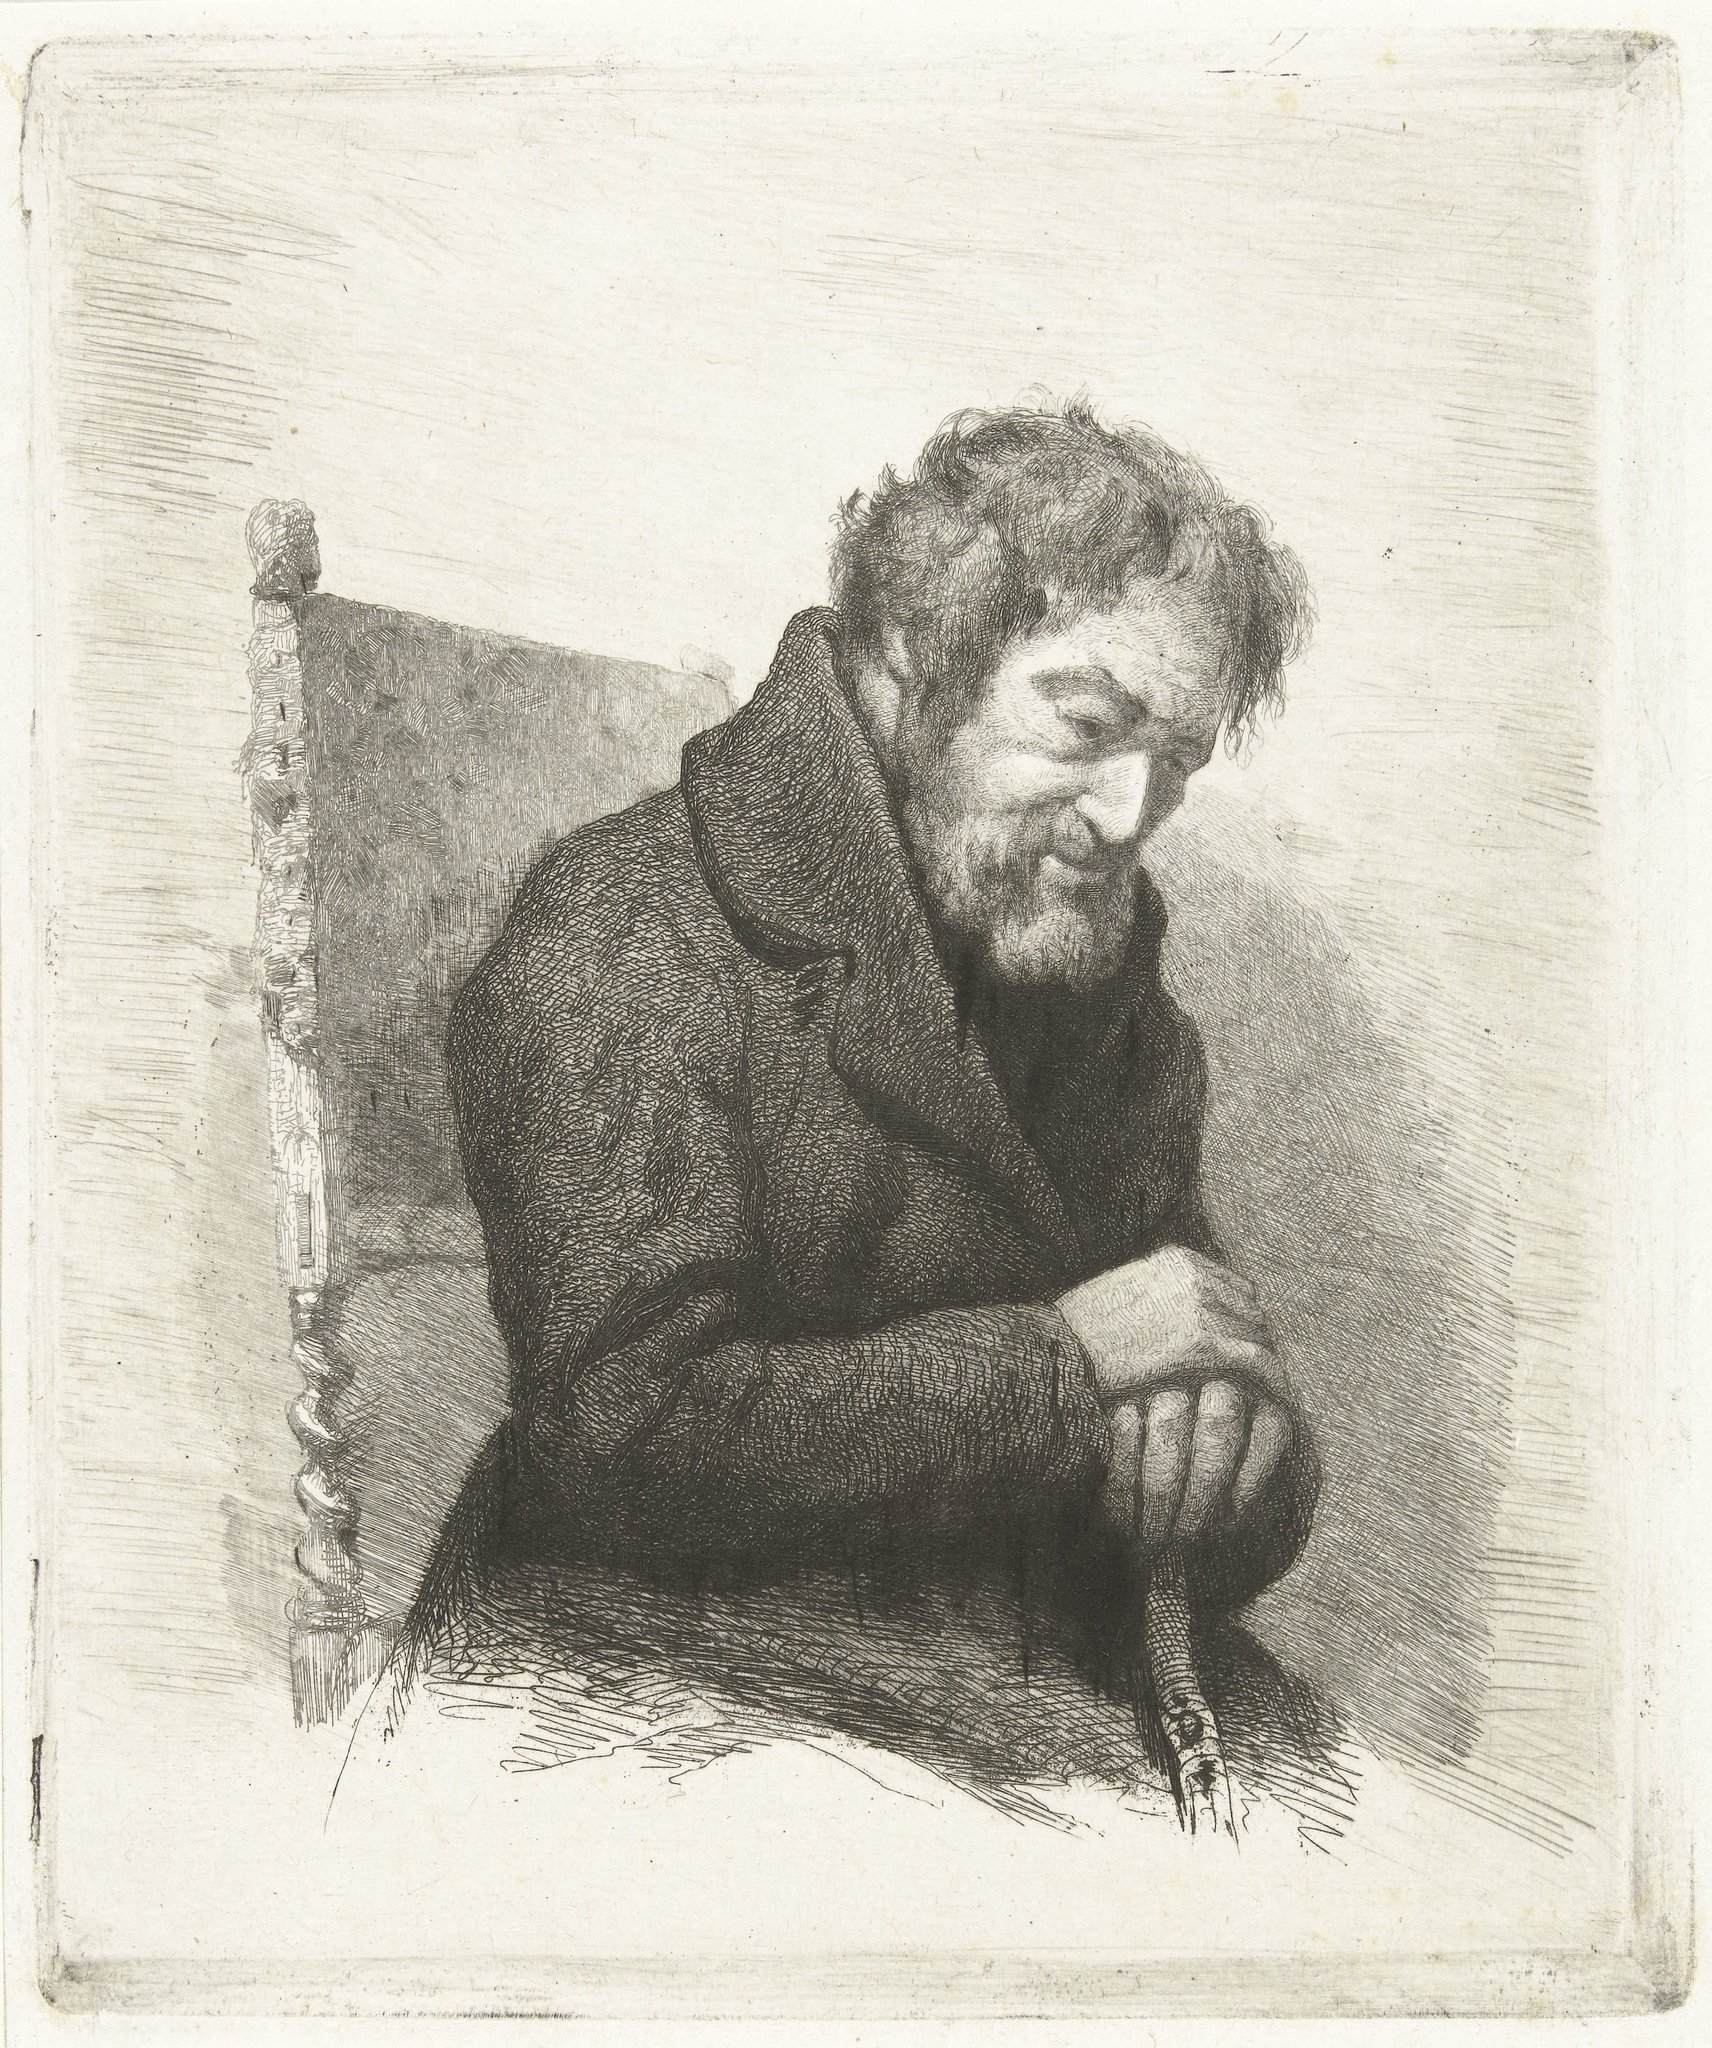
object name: print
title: Zittende grijsaard met wandelstok in zijn handen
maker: pierre louis dubourcq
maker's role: draughtsman, painter, print maker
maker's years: 1815-1873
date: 1845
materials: paper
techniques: etching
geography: netherlands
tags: old man